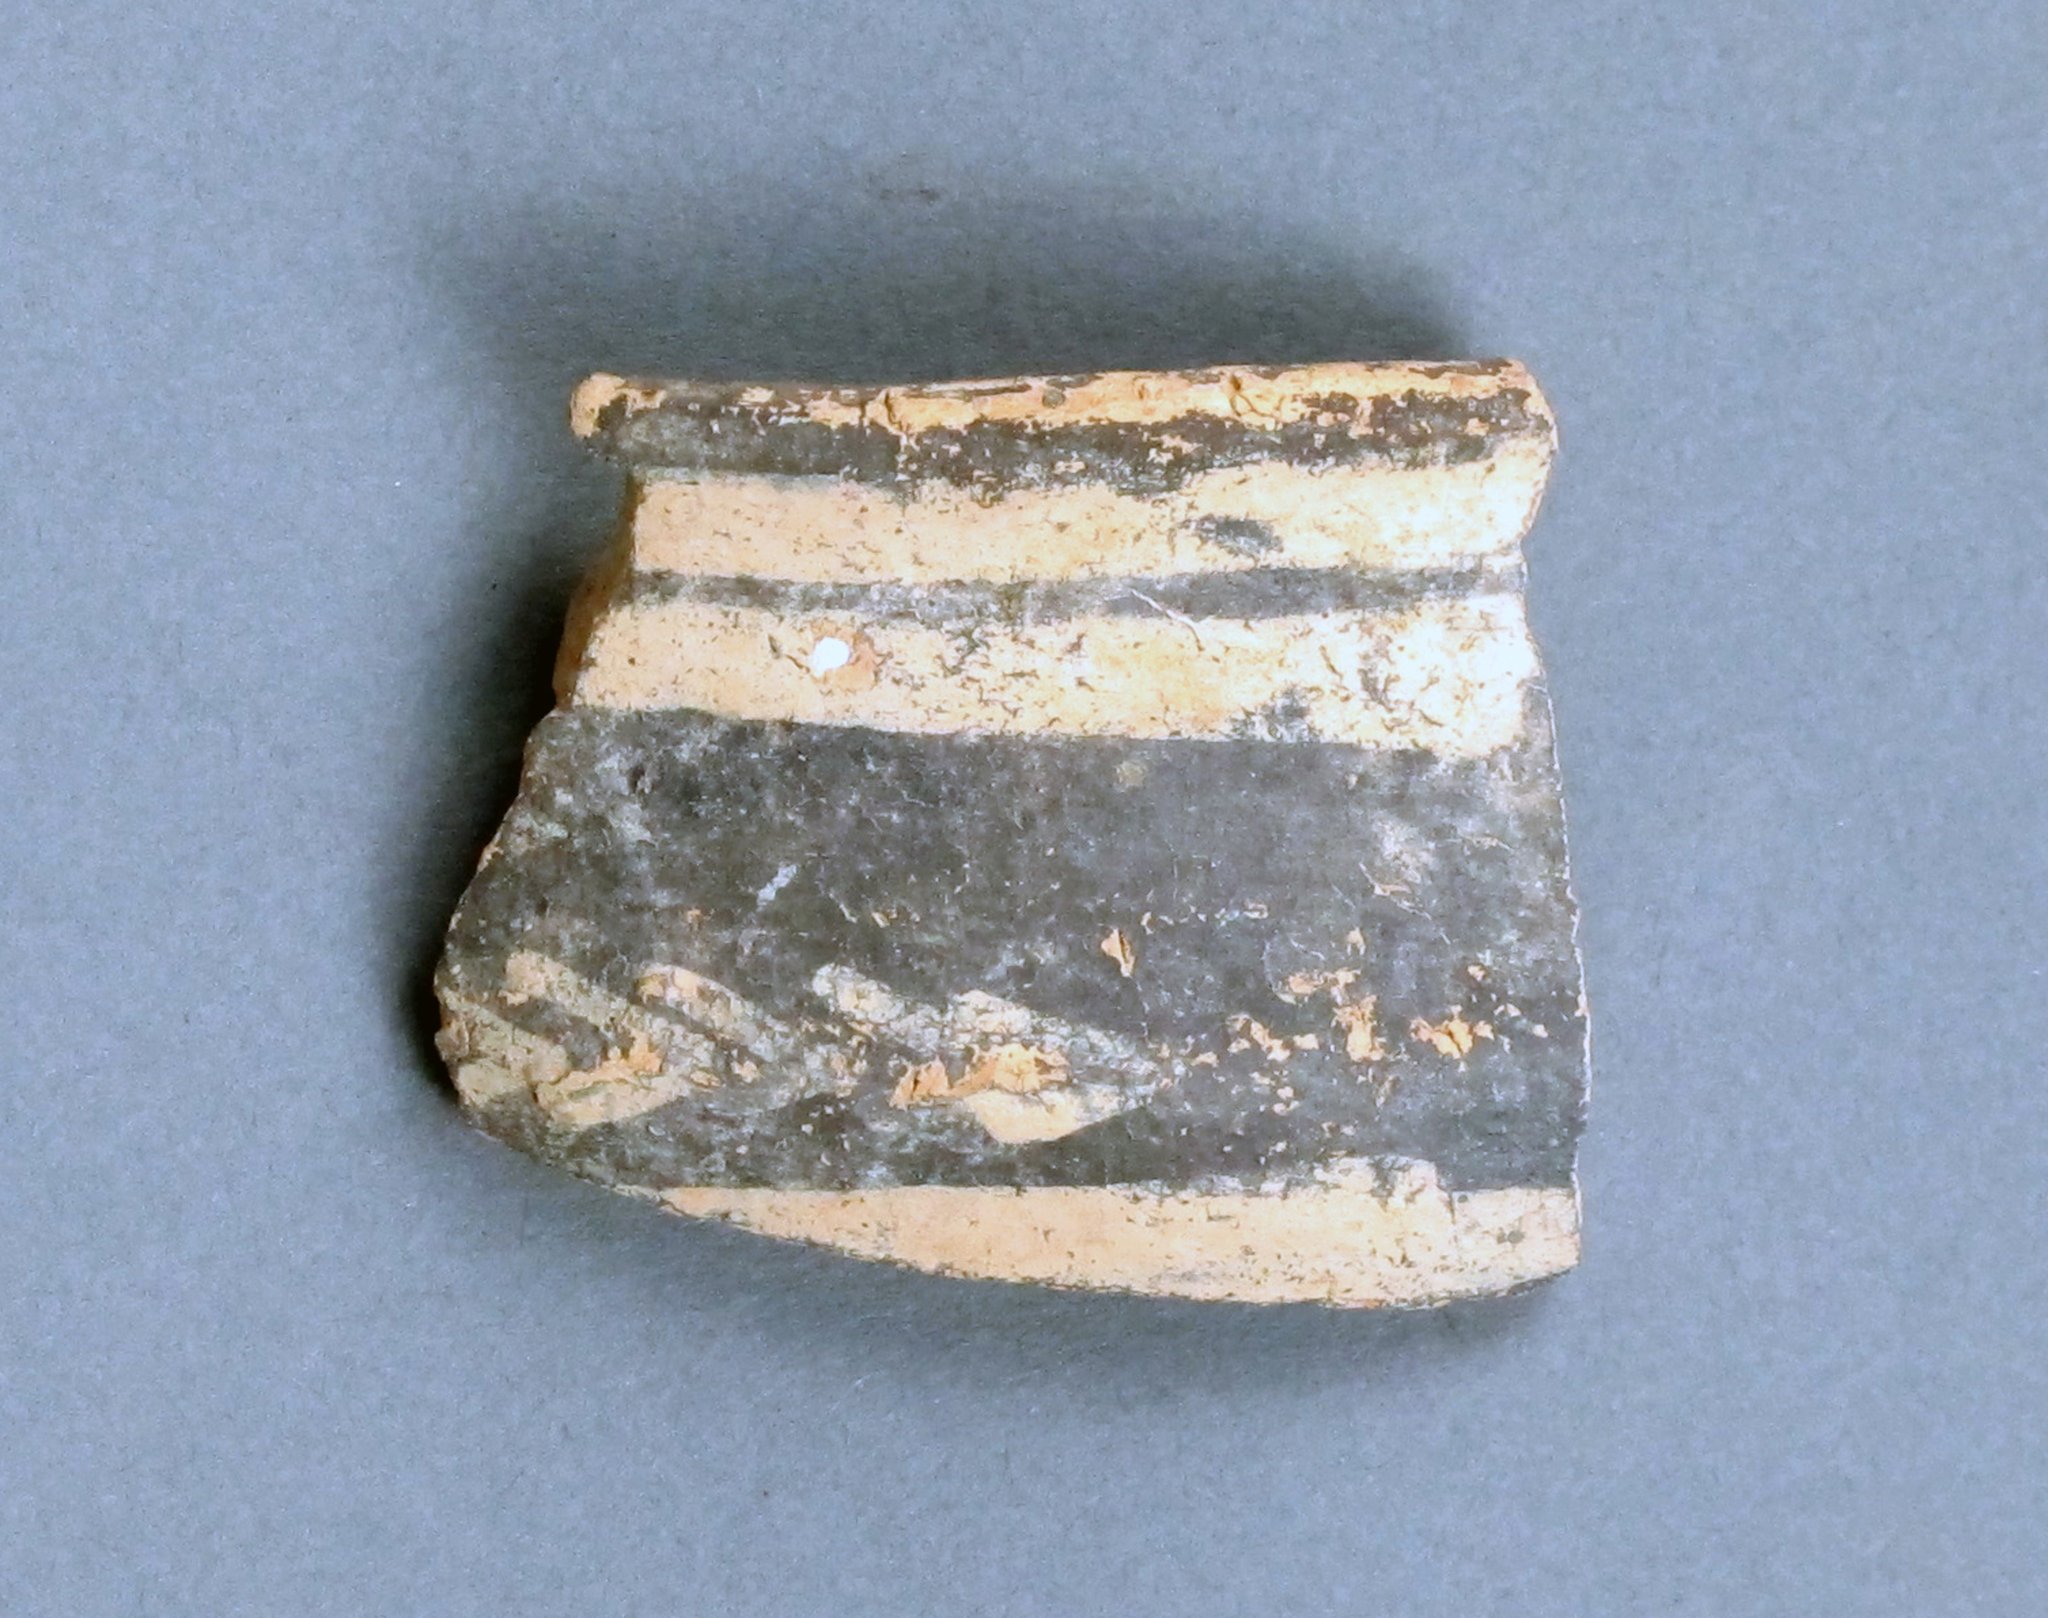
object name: vase fragment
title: Terracotta rim fragment with linear motifs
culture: minoan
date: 2300-2100 BCE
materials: terracotta